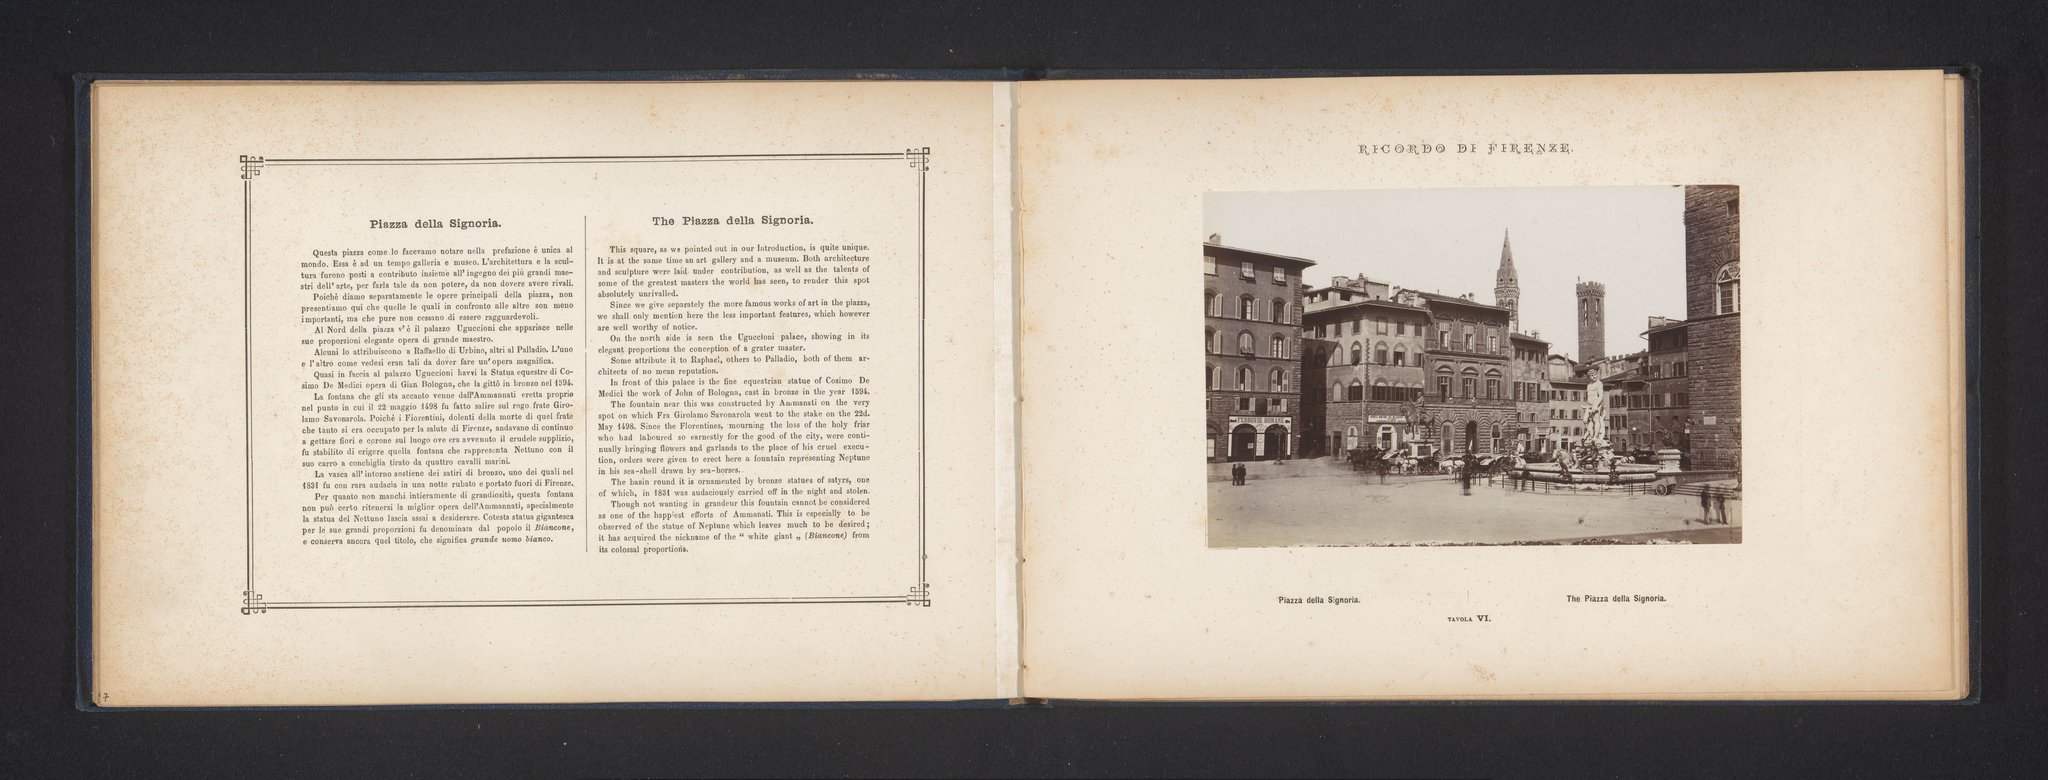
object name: photograph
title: Ricordo di Firenze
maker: giacomo brogi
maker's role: fotograaf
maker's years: 1822-1881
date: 1861-1871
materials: photographic support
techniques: albumen print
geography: florence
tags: cosimo i de' medici, square, place, circus, etc., equestrian statue, ornamental fountain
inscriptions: number: ‘Tavola VI.’